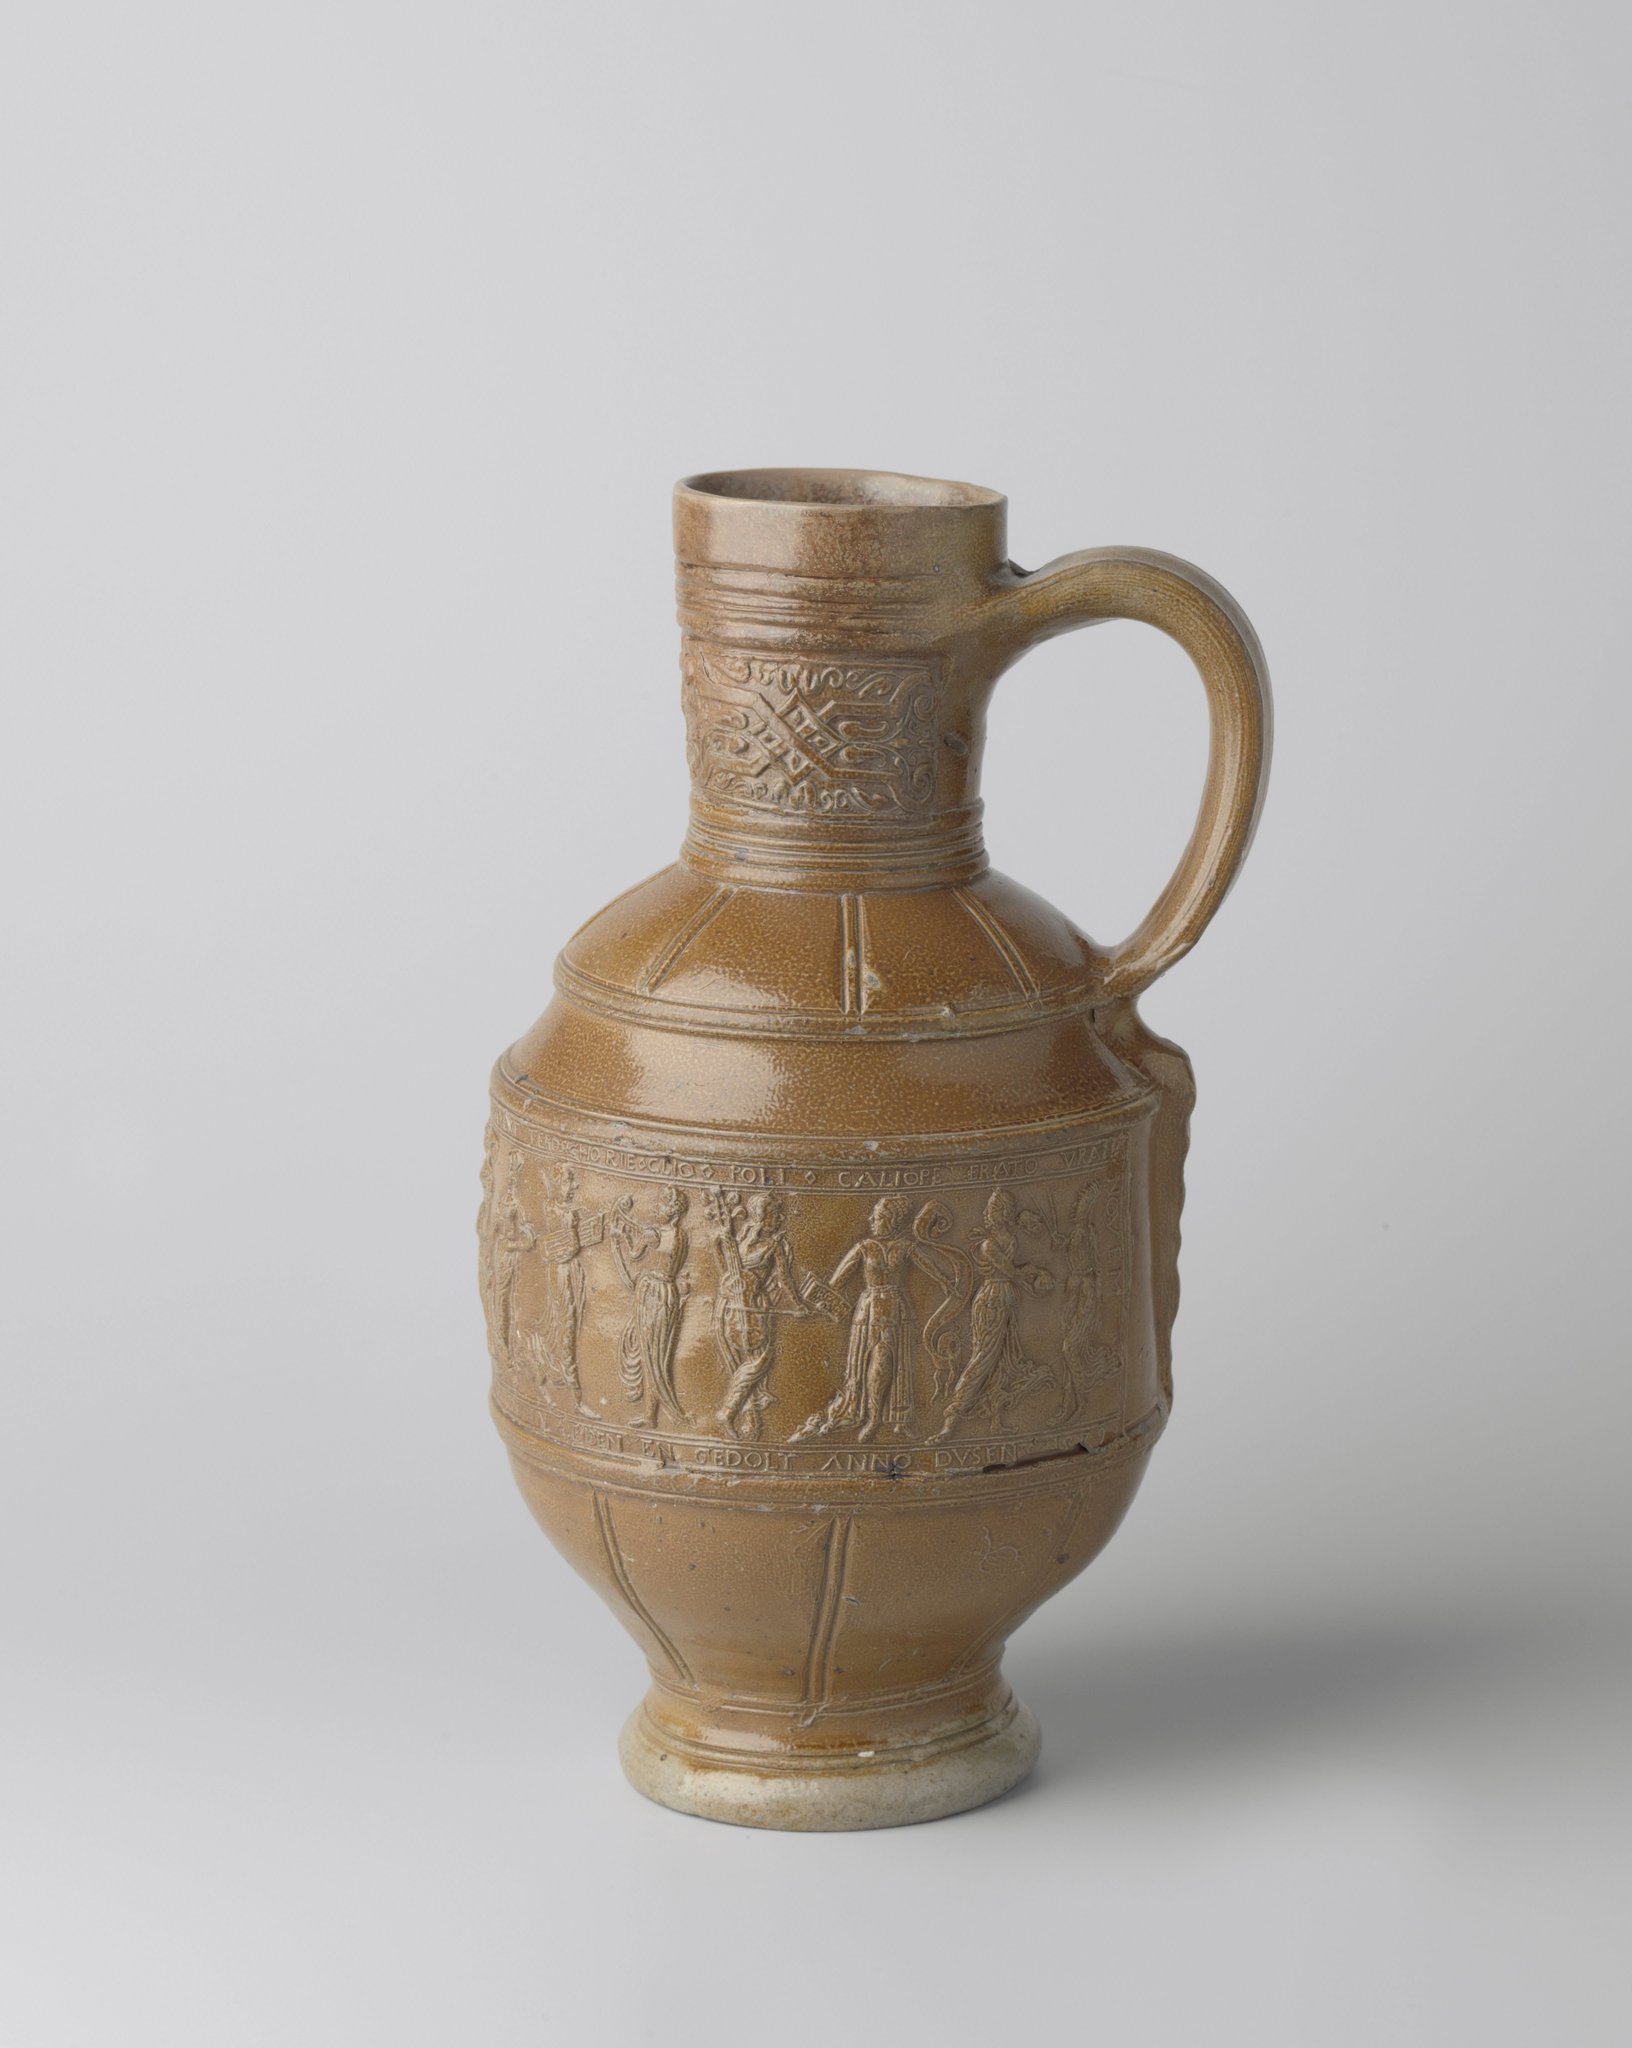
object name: jug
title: Jug with seventeen personifications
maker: Anonymous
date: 1579-1600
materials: engobe, glaze, stoneware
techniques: firing, forming, relief, turning, vitrification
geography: raeren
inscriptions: inscription: ‘Astrologia, Fides, Caritas, Spes, Iustitia, Prvdencia, Temperatia, Fortitvdo, Pelpomene, Tialia, Evt[?], Terpsichorie, Clio, Poli, Caliope, Erato, Vrania’, inscription: ‘BEI MEI MISTER BALDEM MENNICKIN POTENBECKER WONENDE TOTEN RAREN IN LEIDEN EN GEDOLT ANNO DVSENT 1579’, inscription: ‘NOVEM’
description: Kruik van steengoed op hoge voet met een cilindervormig lichaam met iets smallere, ronde schouder en lange nek. Het C-vormige oor is bevestigd aan de nek en de schouder. Bedekt met een bruine engobe. Op de buik een brede band met in reliëf een gedrukte en opgelegde versiering van zeventien personificaties met daarboven hun benamingen. Weergegeven zijn astrologie, de Zeven Deugden en de Negen Muzen: Astrologia, Fides, Caritas, Spes, Iustitia, Prvdencia, Temperatia, Fortitvdo, Pelpomene, Tialia, Evt[?], Terpsichorie, Clio, Poli, Caliope, Erato, Vrania. Onder de vrouwfiguren het opschrift 'BEI MEI MISTER BALDEM MENNICKIN POTENBECKER WONENDE TOTEN RAREN IN LEIDEN EN GEDOLT ANNO DVSENT 1579'. Rechts van de laatste dame het woord 'NOVEM'. De schouder en het onderste deel van de buik met ingegrifte vakken. Op de nek een band met krulwerk en ruiten. Raeren.